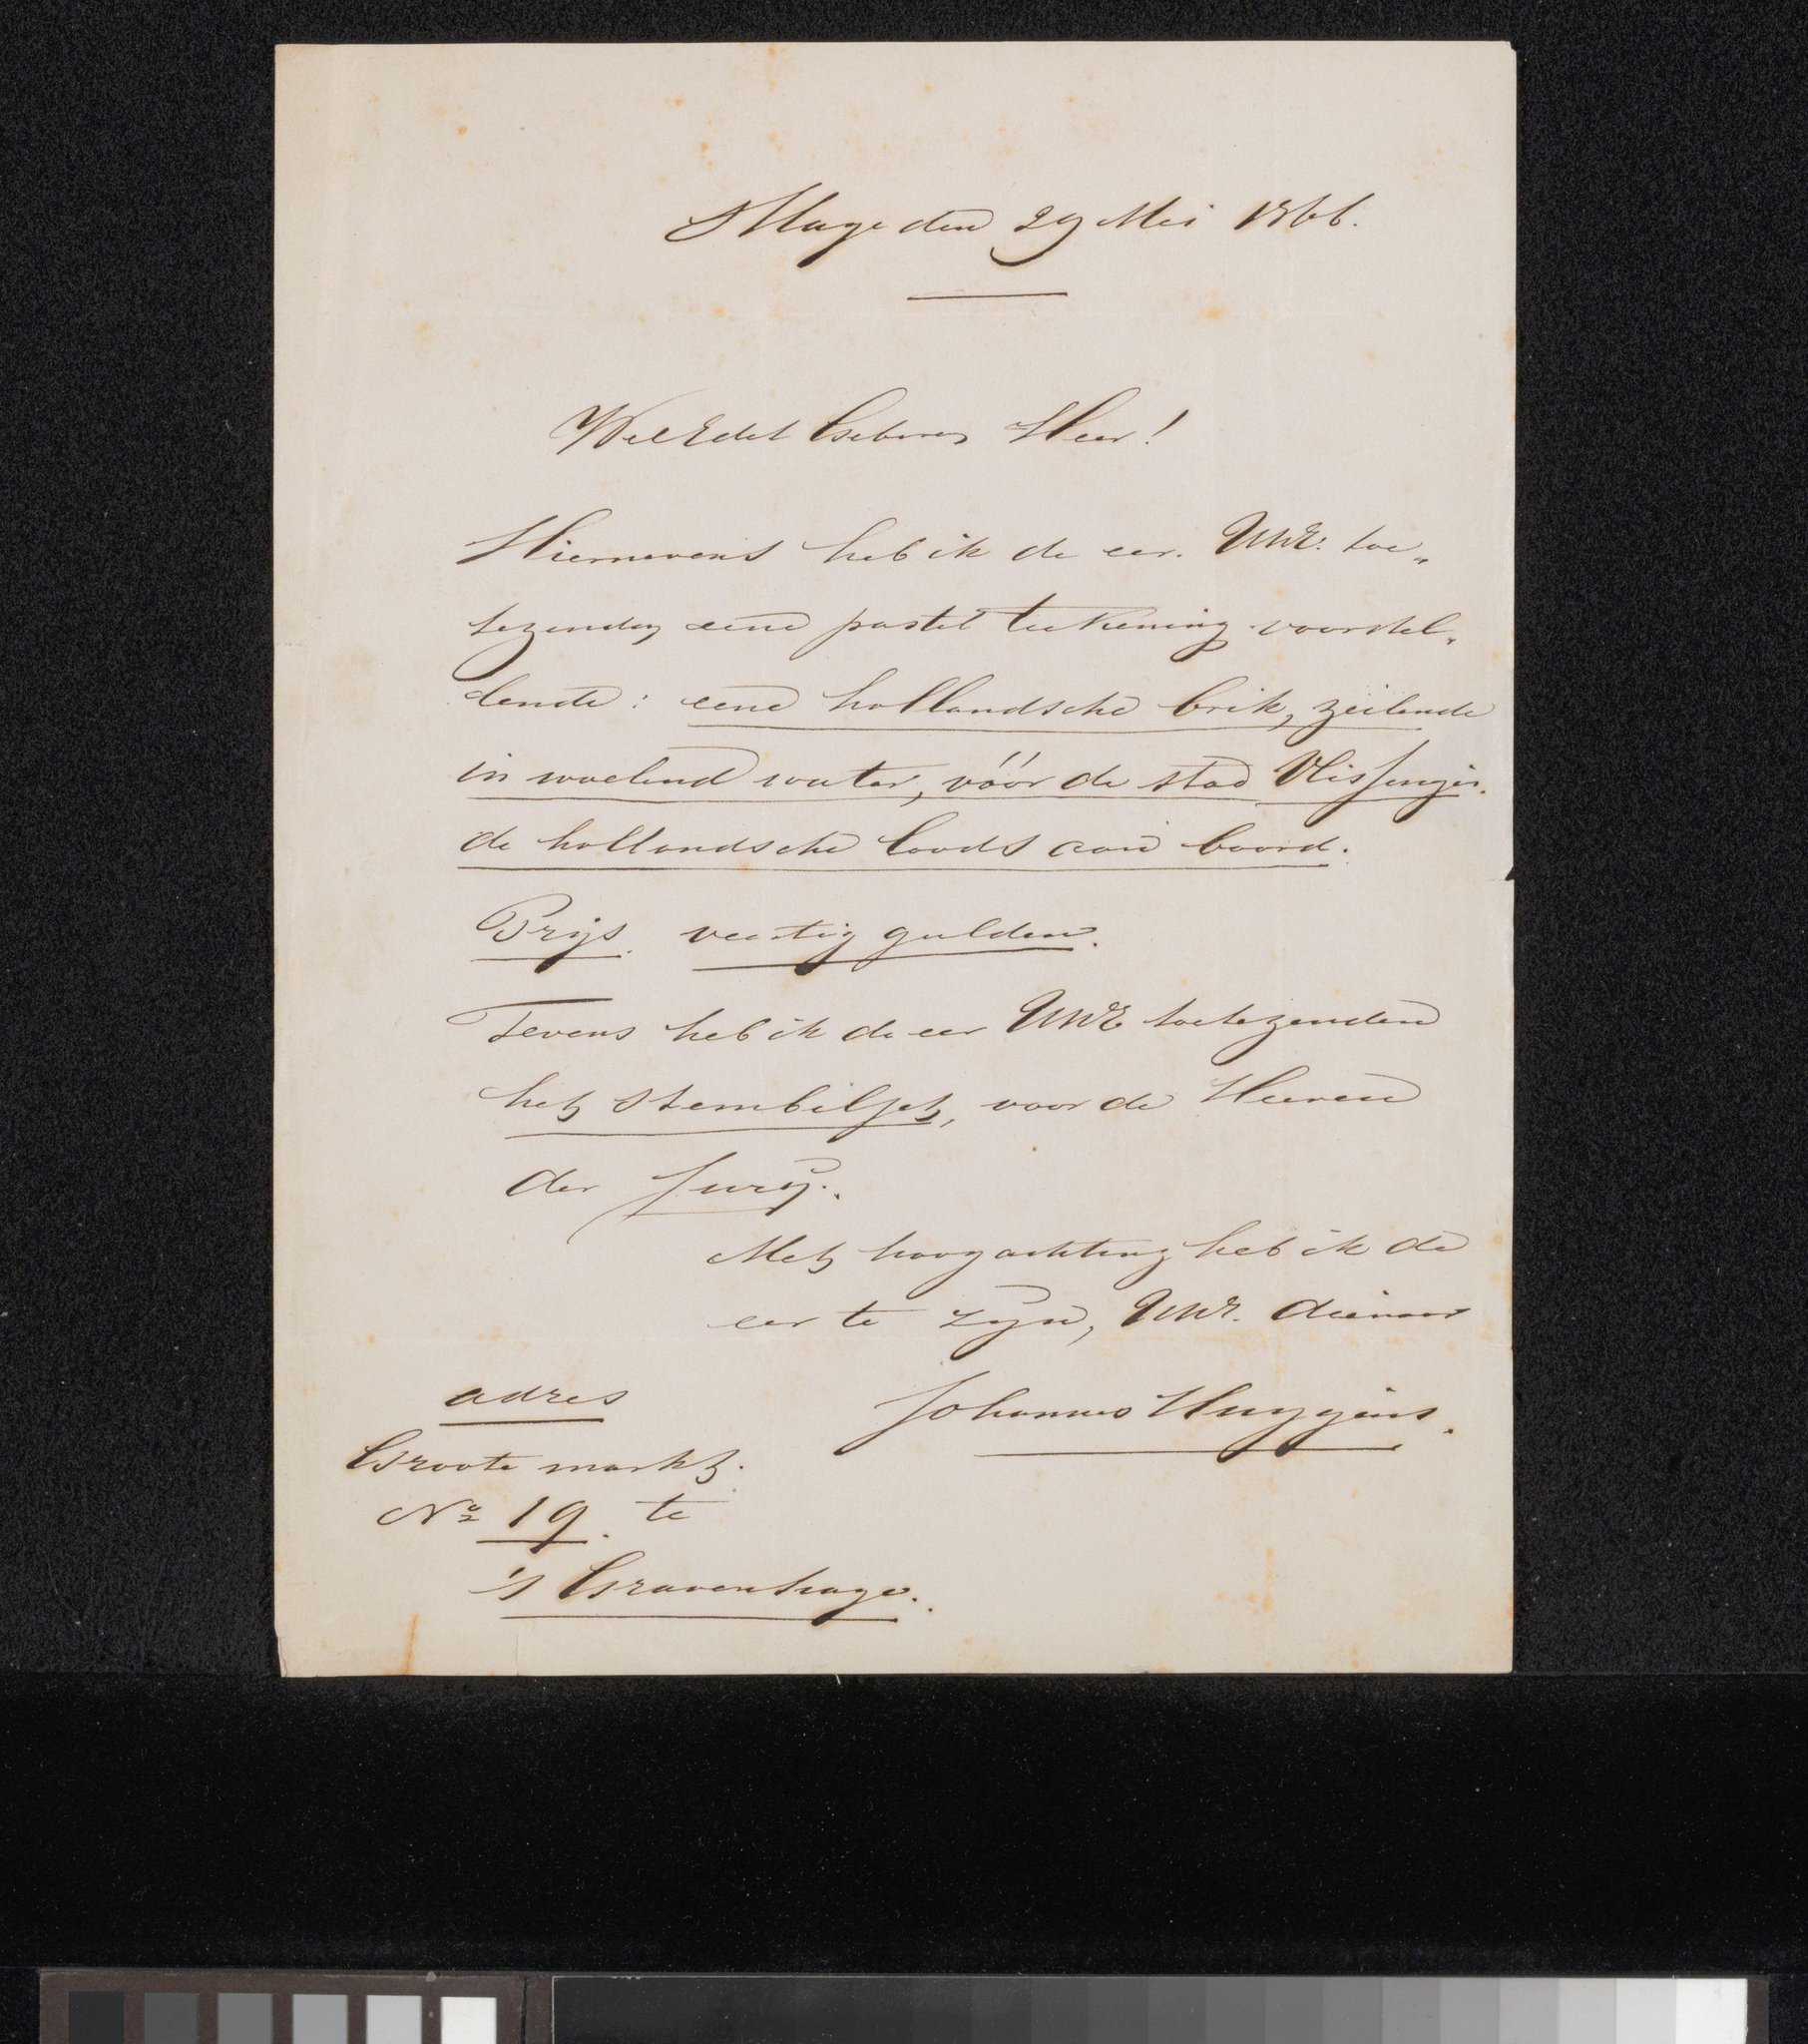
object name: letter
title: Brief aan de Commissie van de Tentoonstelling van Levende Meesters in Utrecht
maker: johannes huygens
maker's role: draughtsman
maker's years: 1833-1911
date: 1866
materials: ink, paper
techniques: pen, writing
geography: the hague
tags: drawing, exhibition ~ art, money, the hague